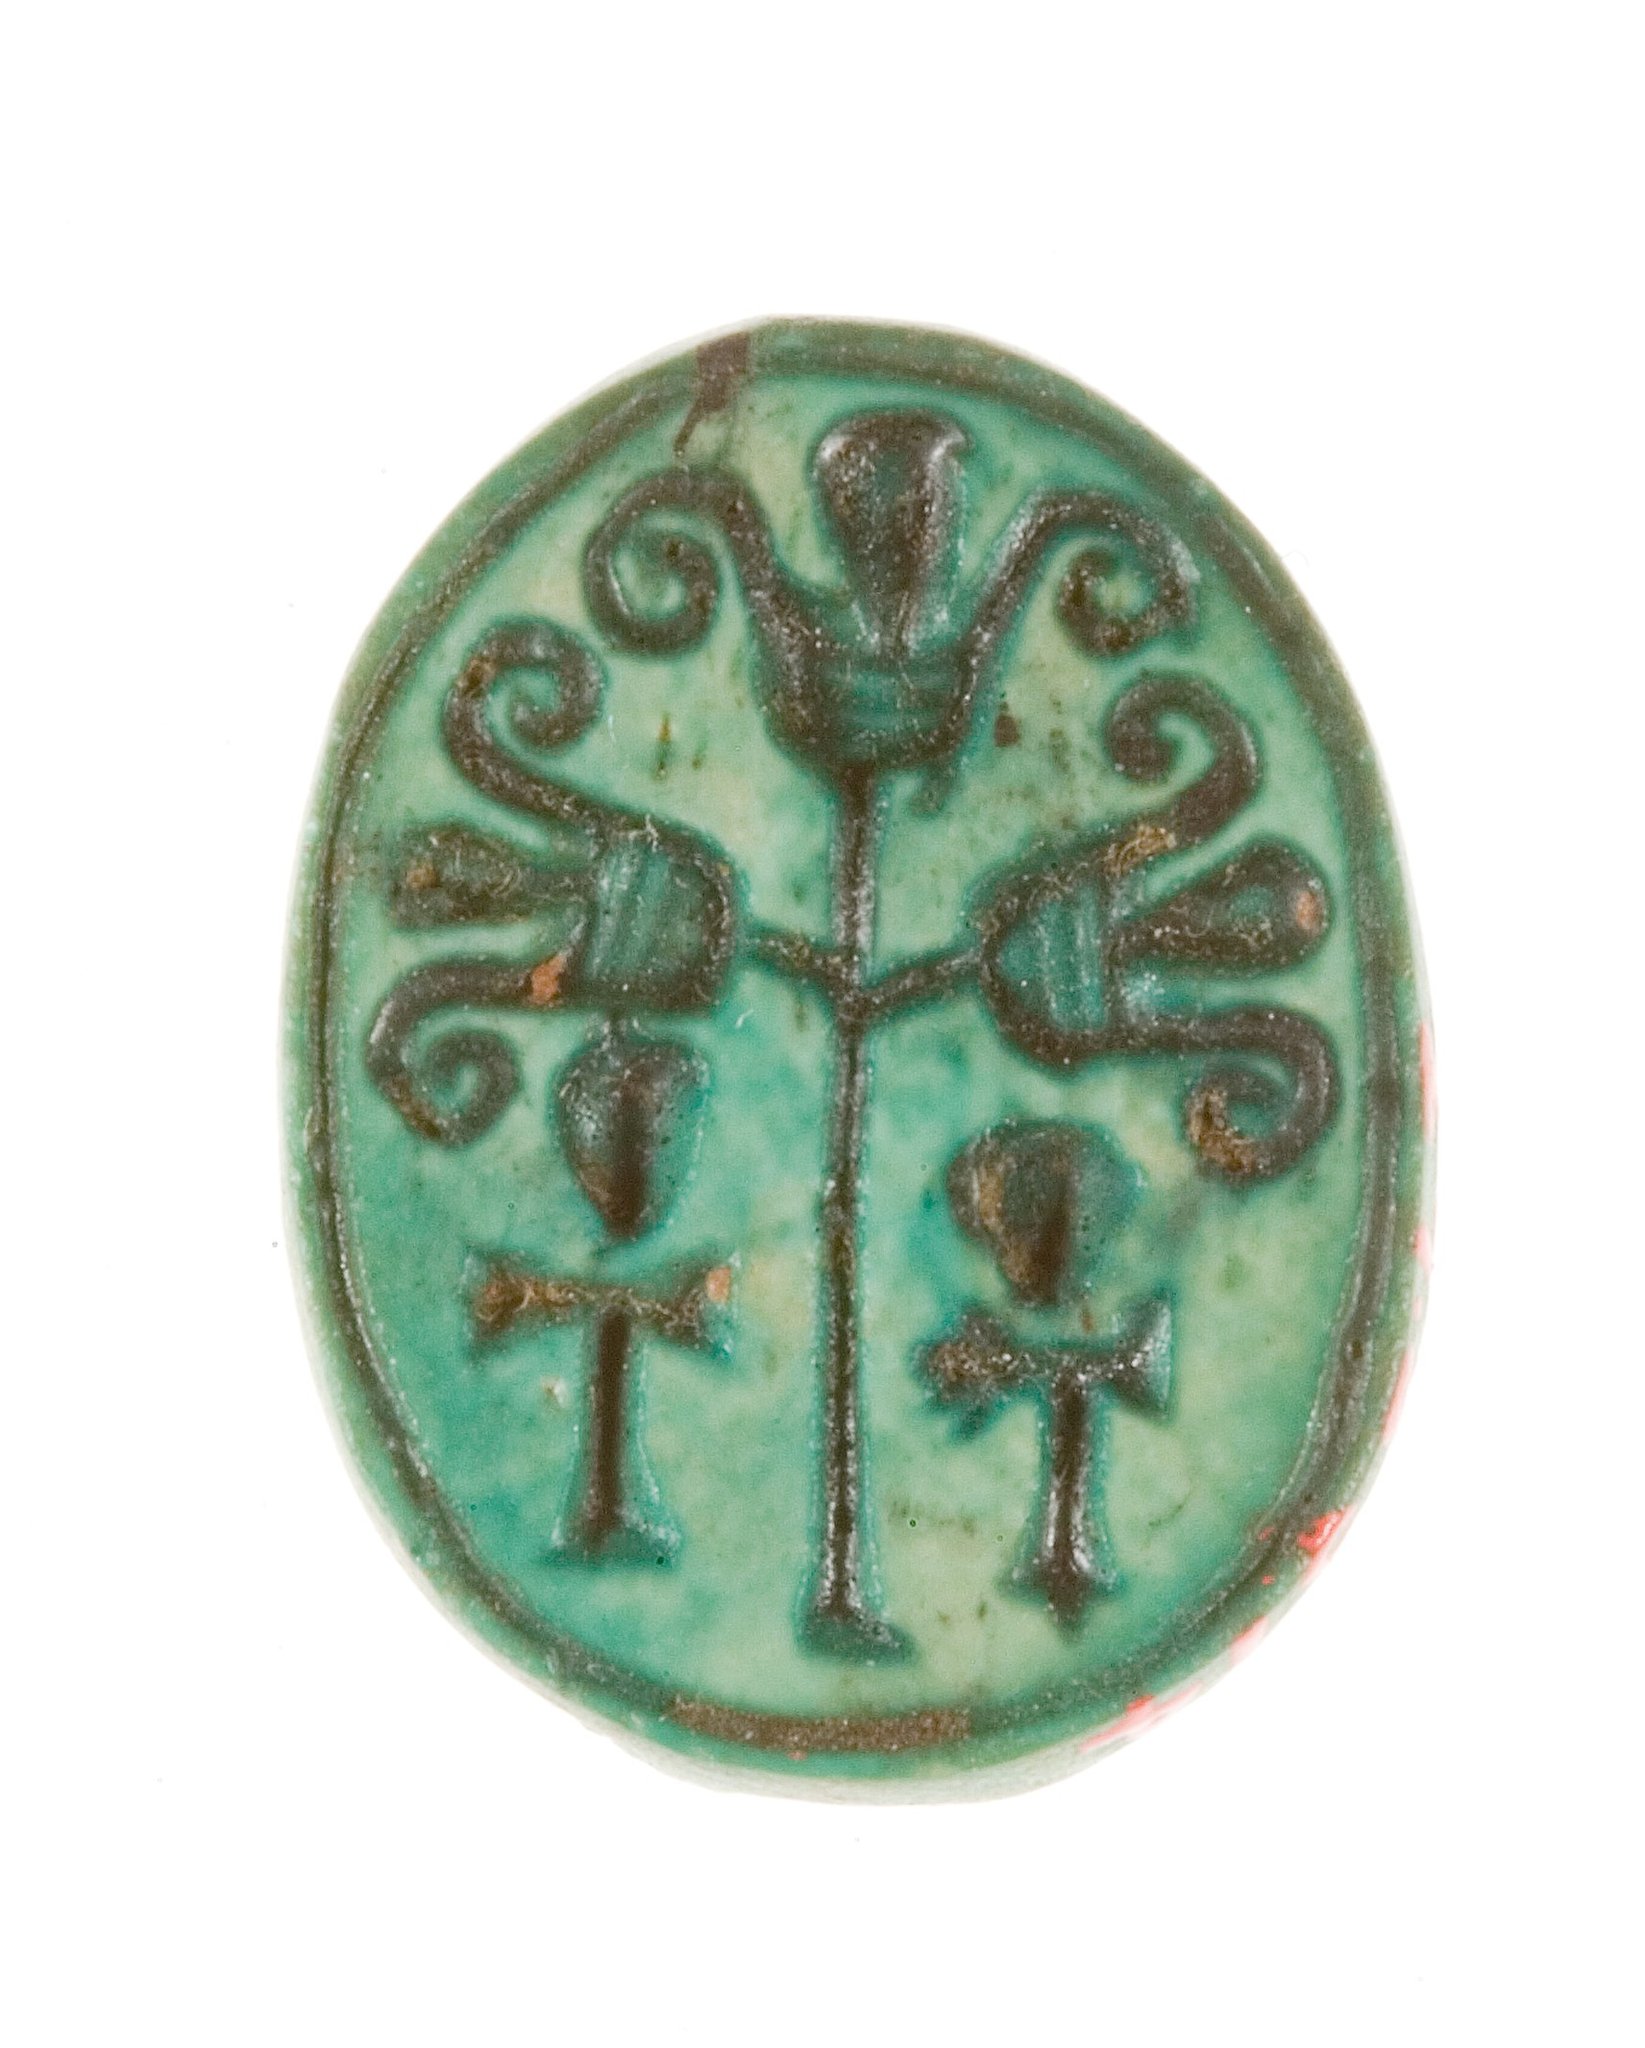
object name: scarab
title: Scarab Inscribed with a Hieroglyphic Motif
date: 1479-1458 BCE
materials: stone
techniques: glazing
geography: egypt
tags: scarabs